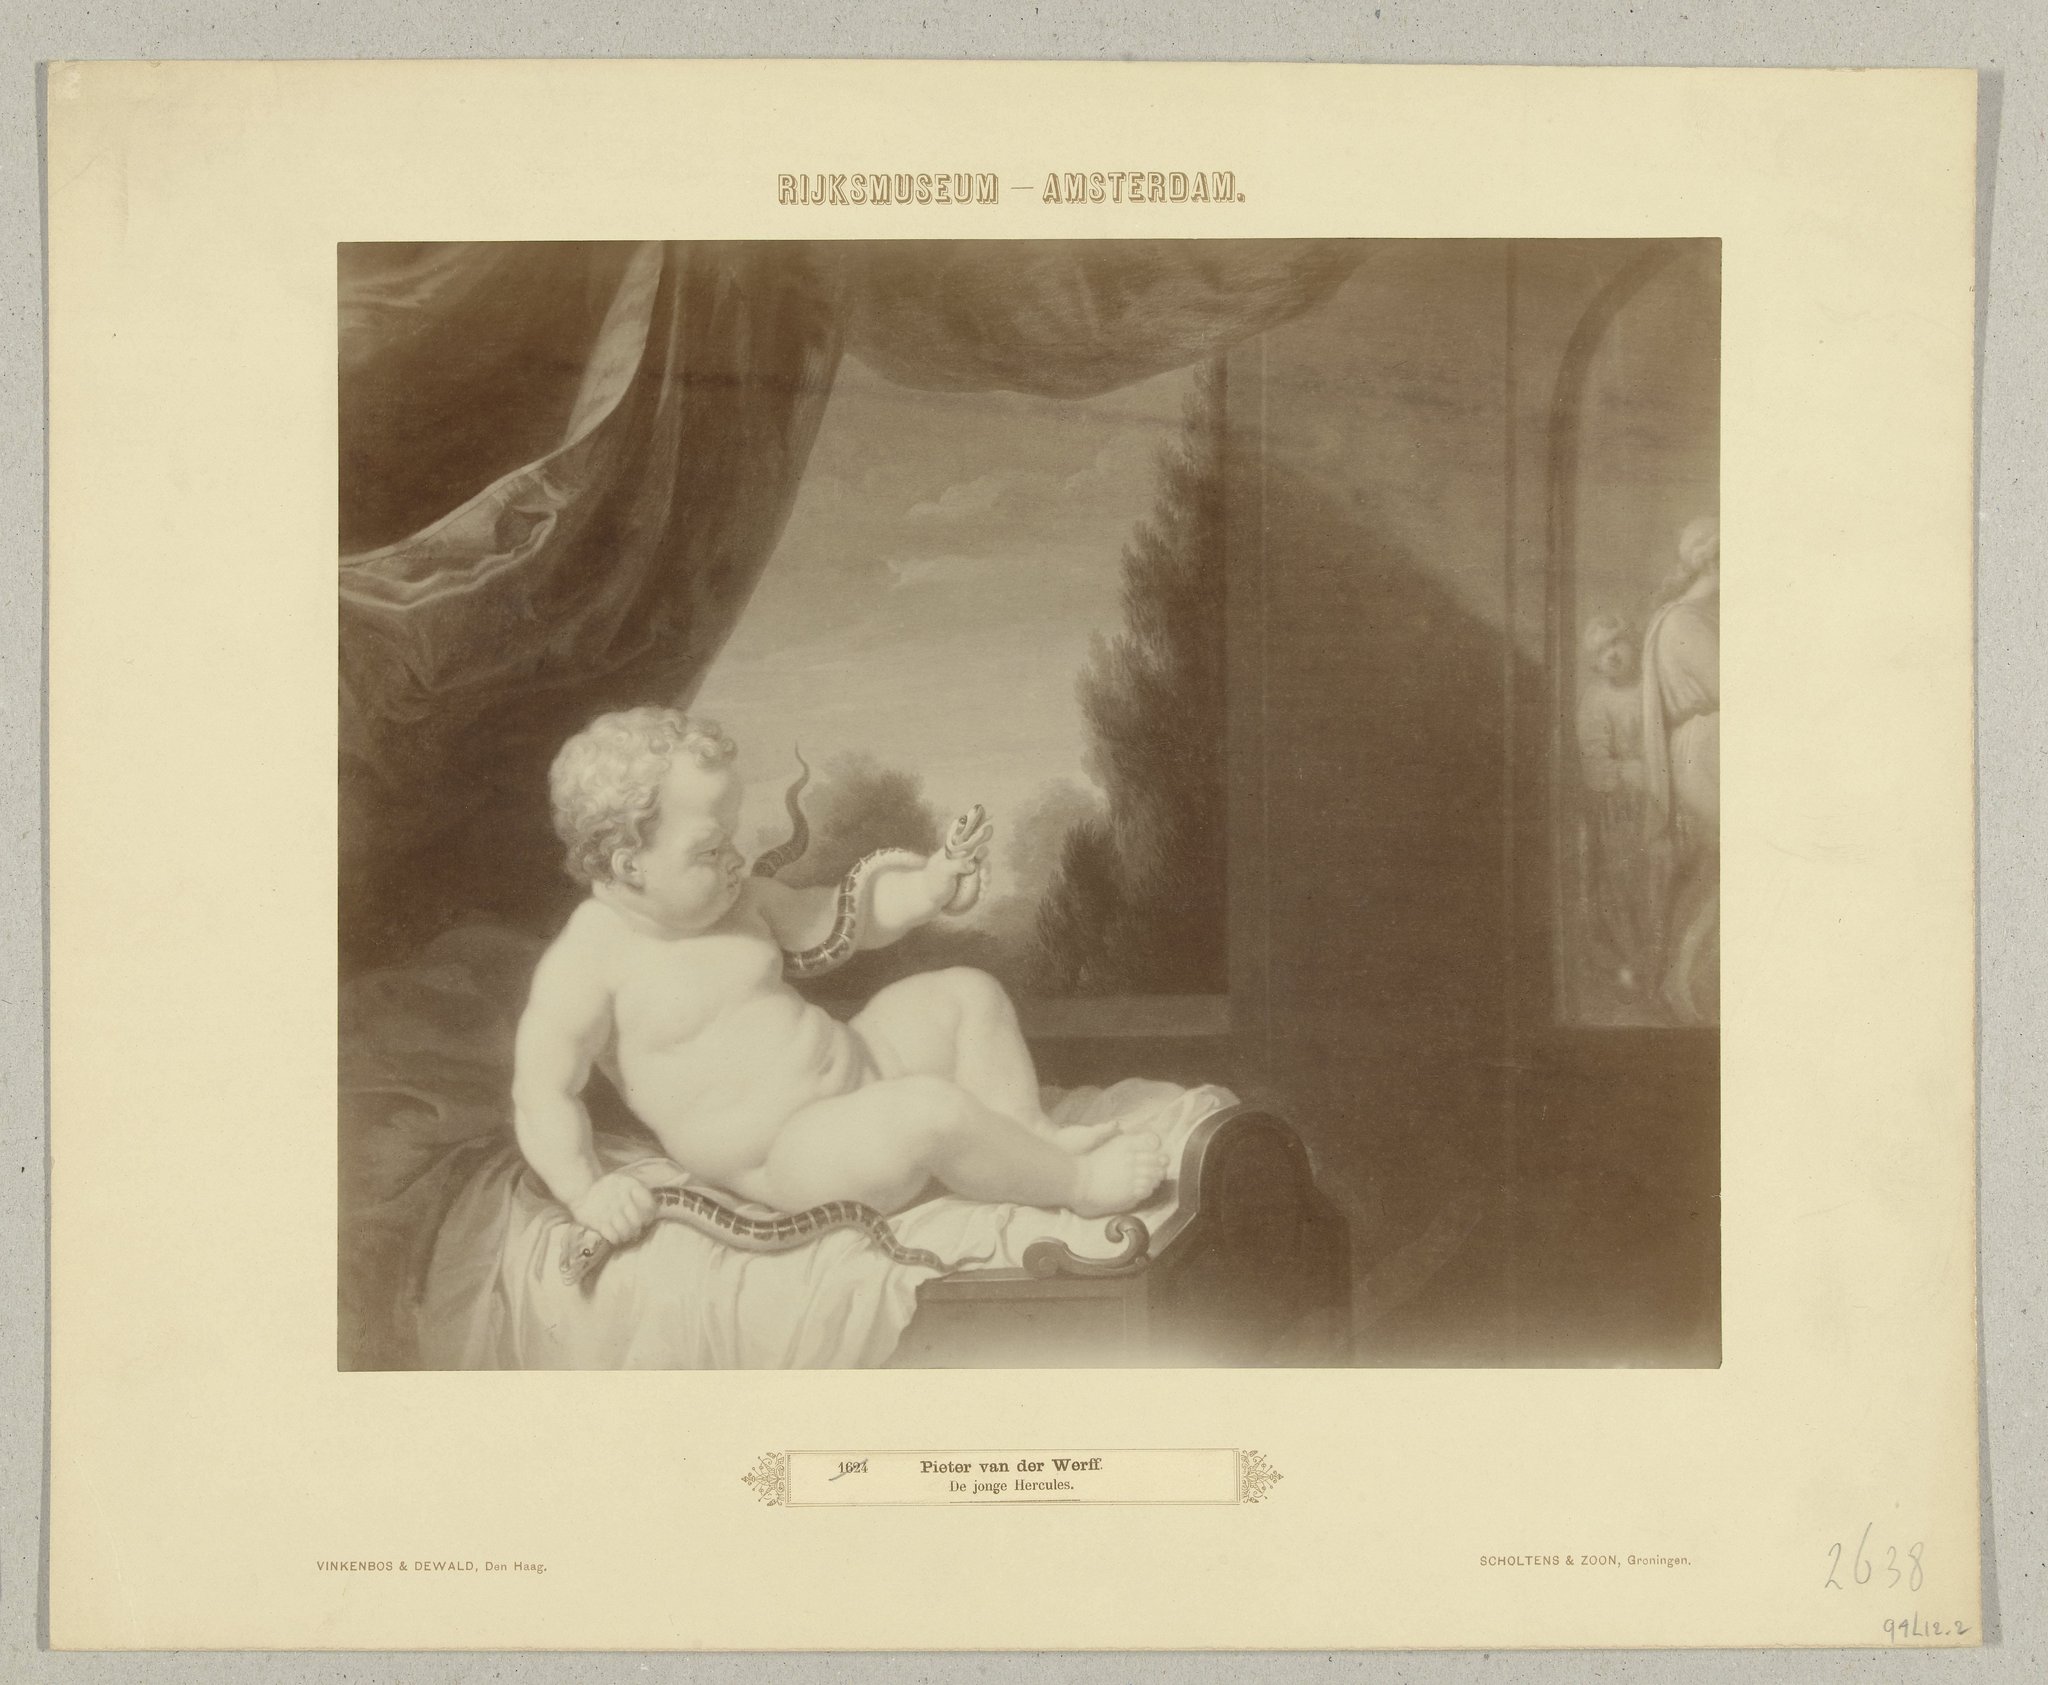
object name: photograph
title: Rijksmuseum - Amsterdam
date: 1890-1910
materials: cardboard, paper, photographic support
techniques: albumen print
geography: groningen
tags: picture, painting